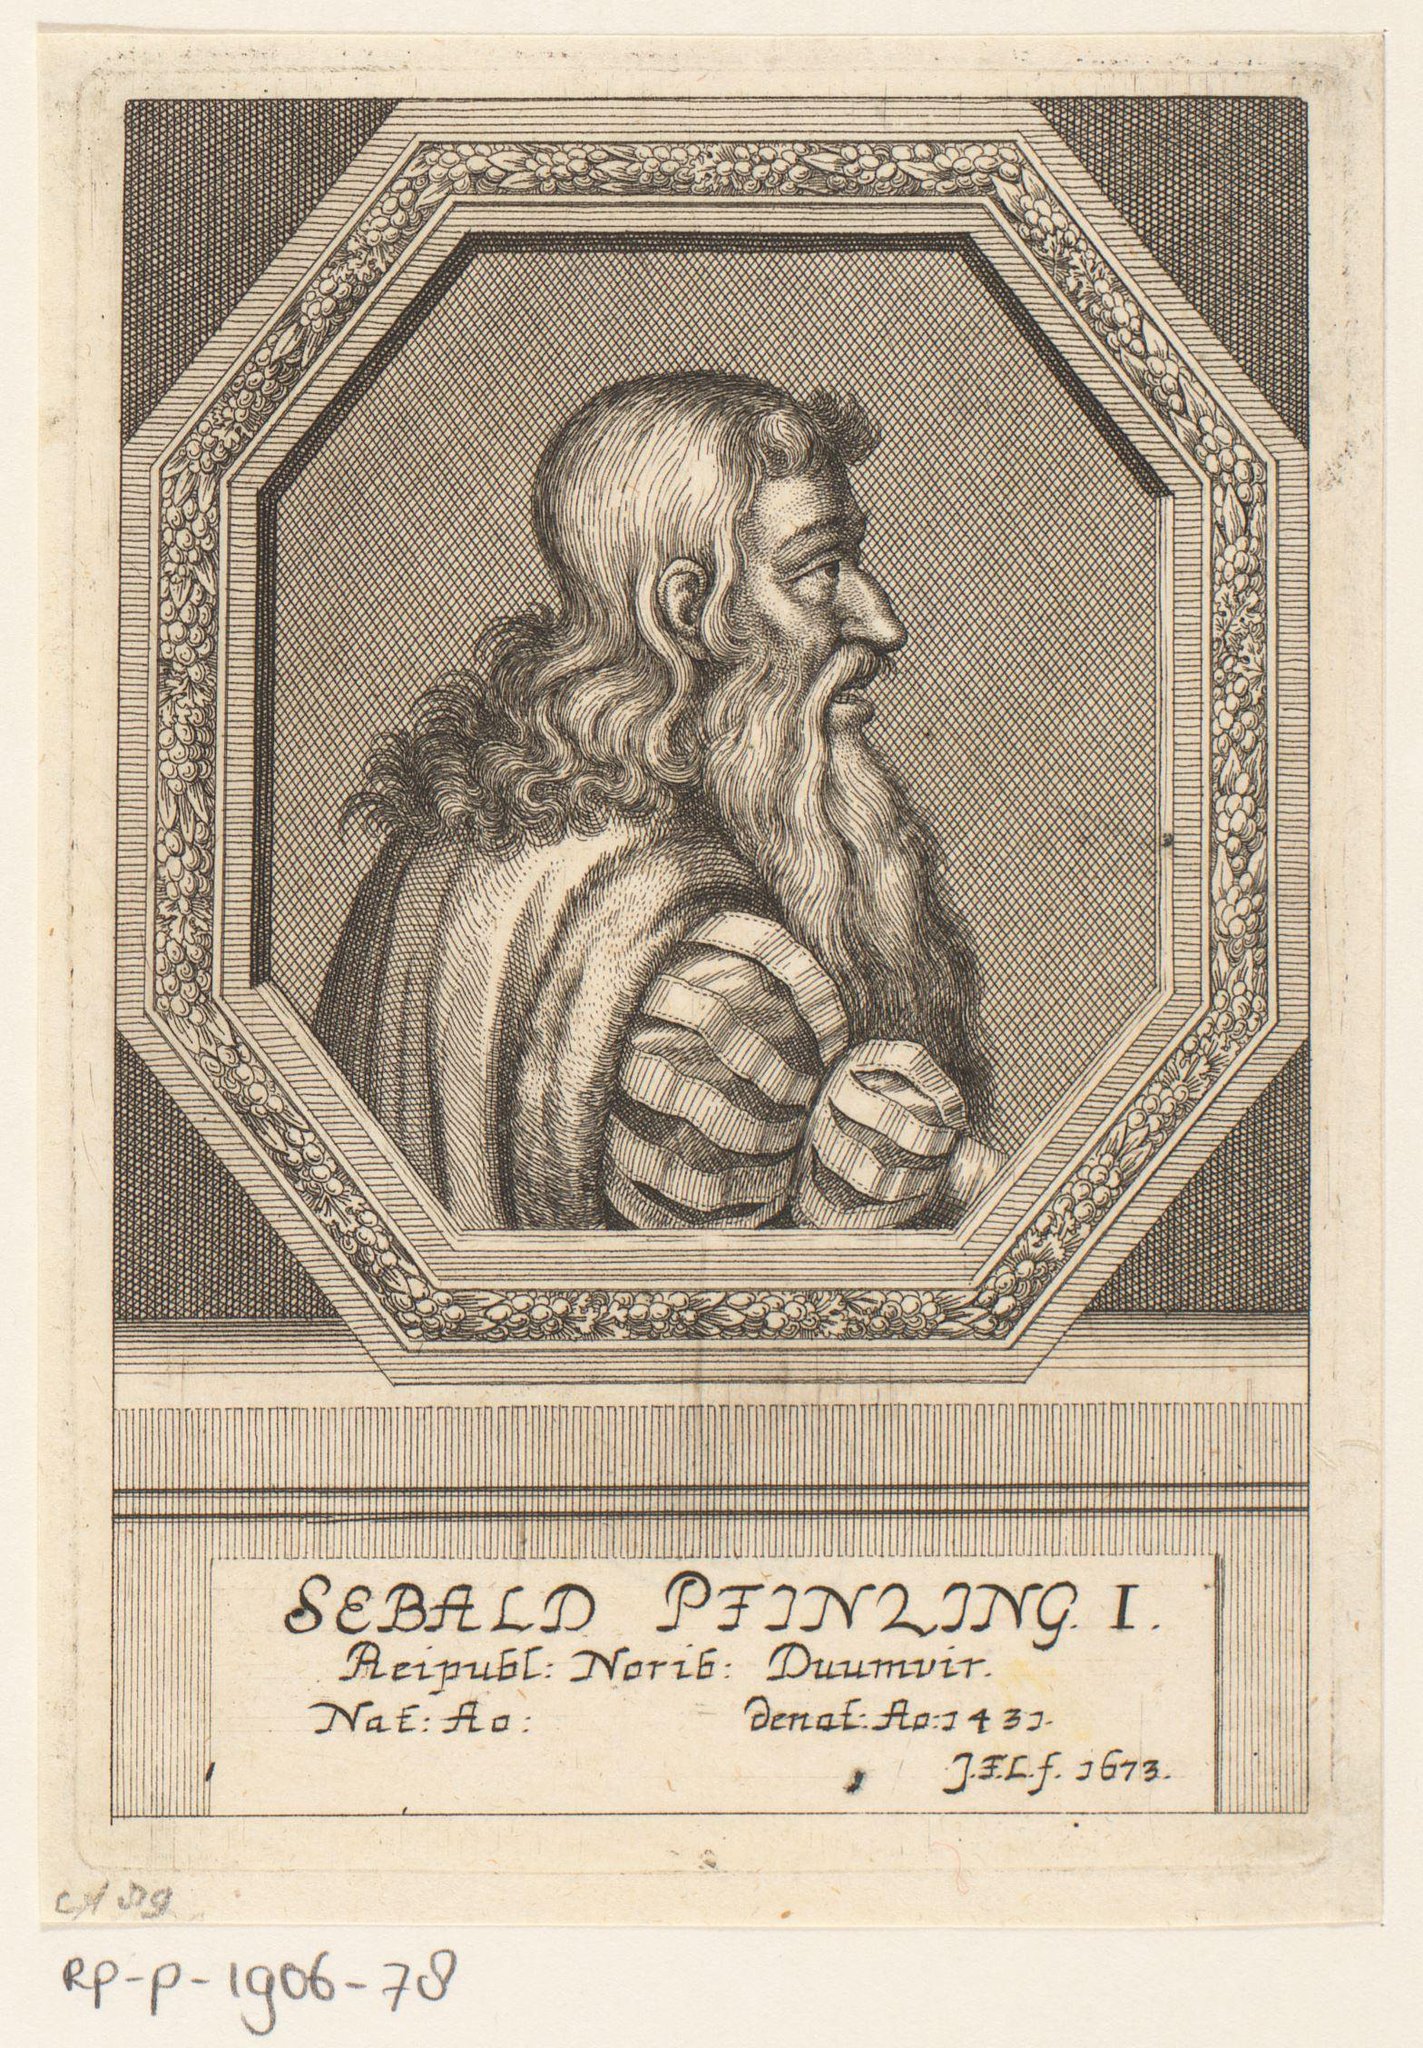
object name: print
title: Portret van Sebald Pfintzing von Hefenfeld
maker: johann friedrich leonard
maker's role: print maker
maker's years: 1633-1680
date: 1673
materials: paper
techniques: engraving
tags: historical persons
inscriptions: collector's mark: Lugt 2228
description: Portret van Sebald Pfintzing von Hefenfeld, magistraat te Neurenberg.